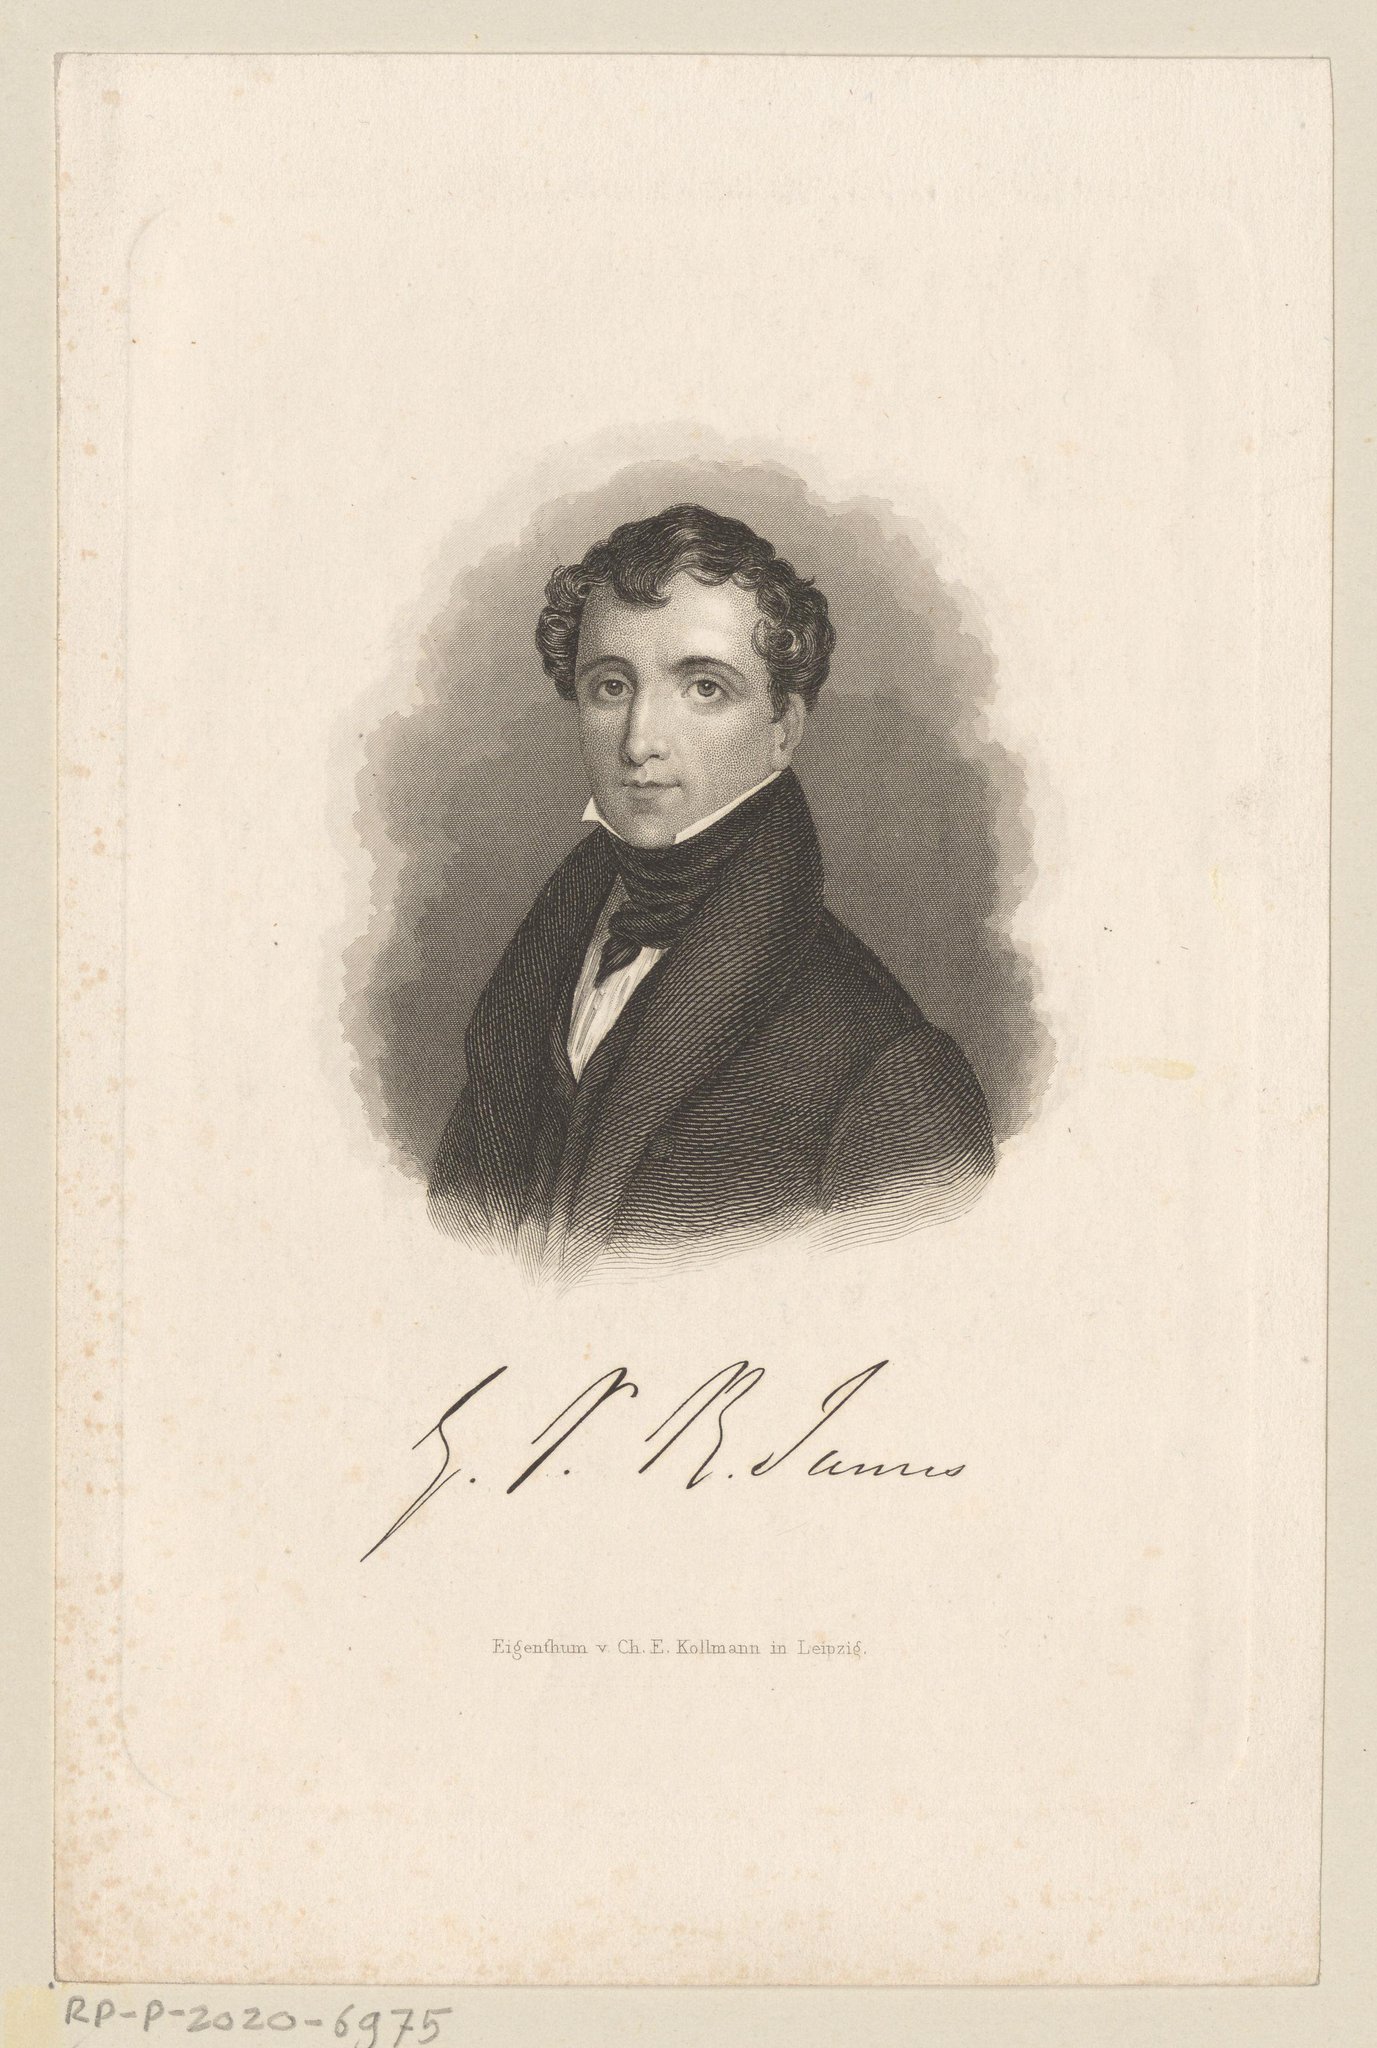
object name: print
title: Portret van George Payne Rainsford James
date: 1818-1855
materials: paper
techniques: engraving, etching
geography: leipzig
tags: historical persons, portrait of a writer